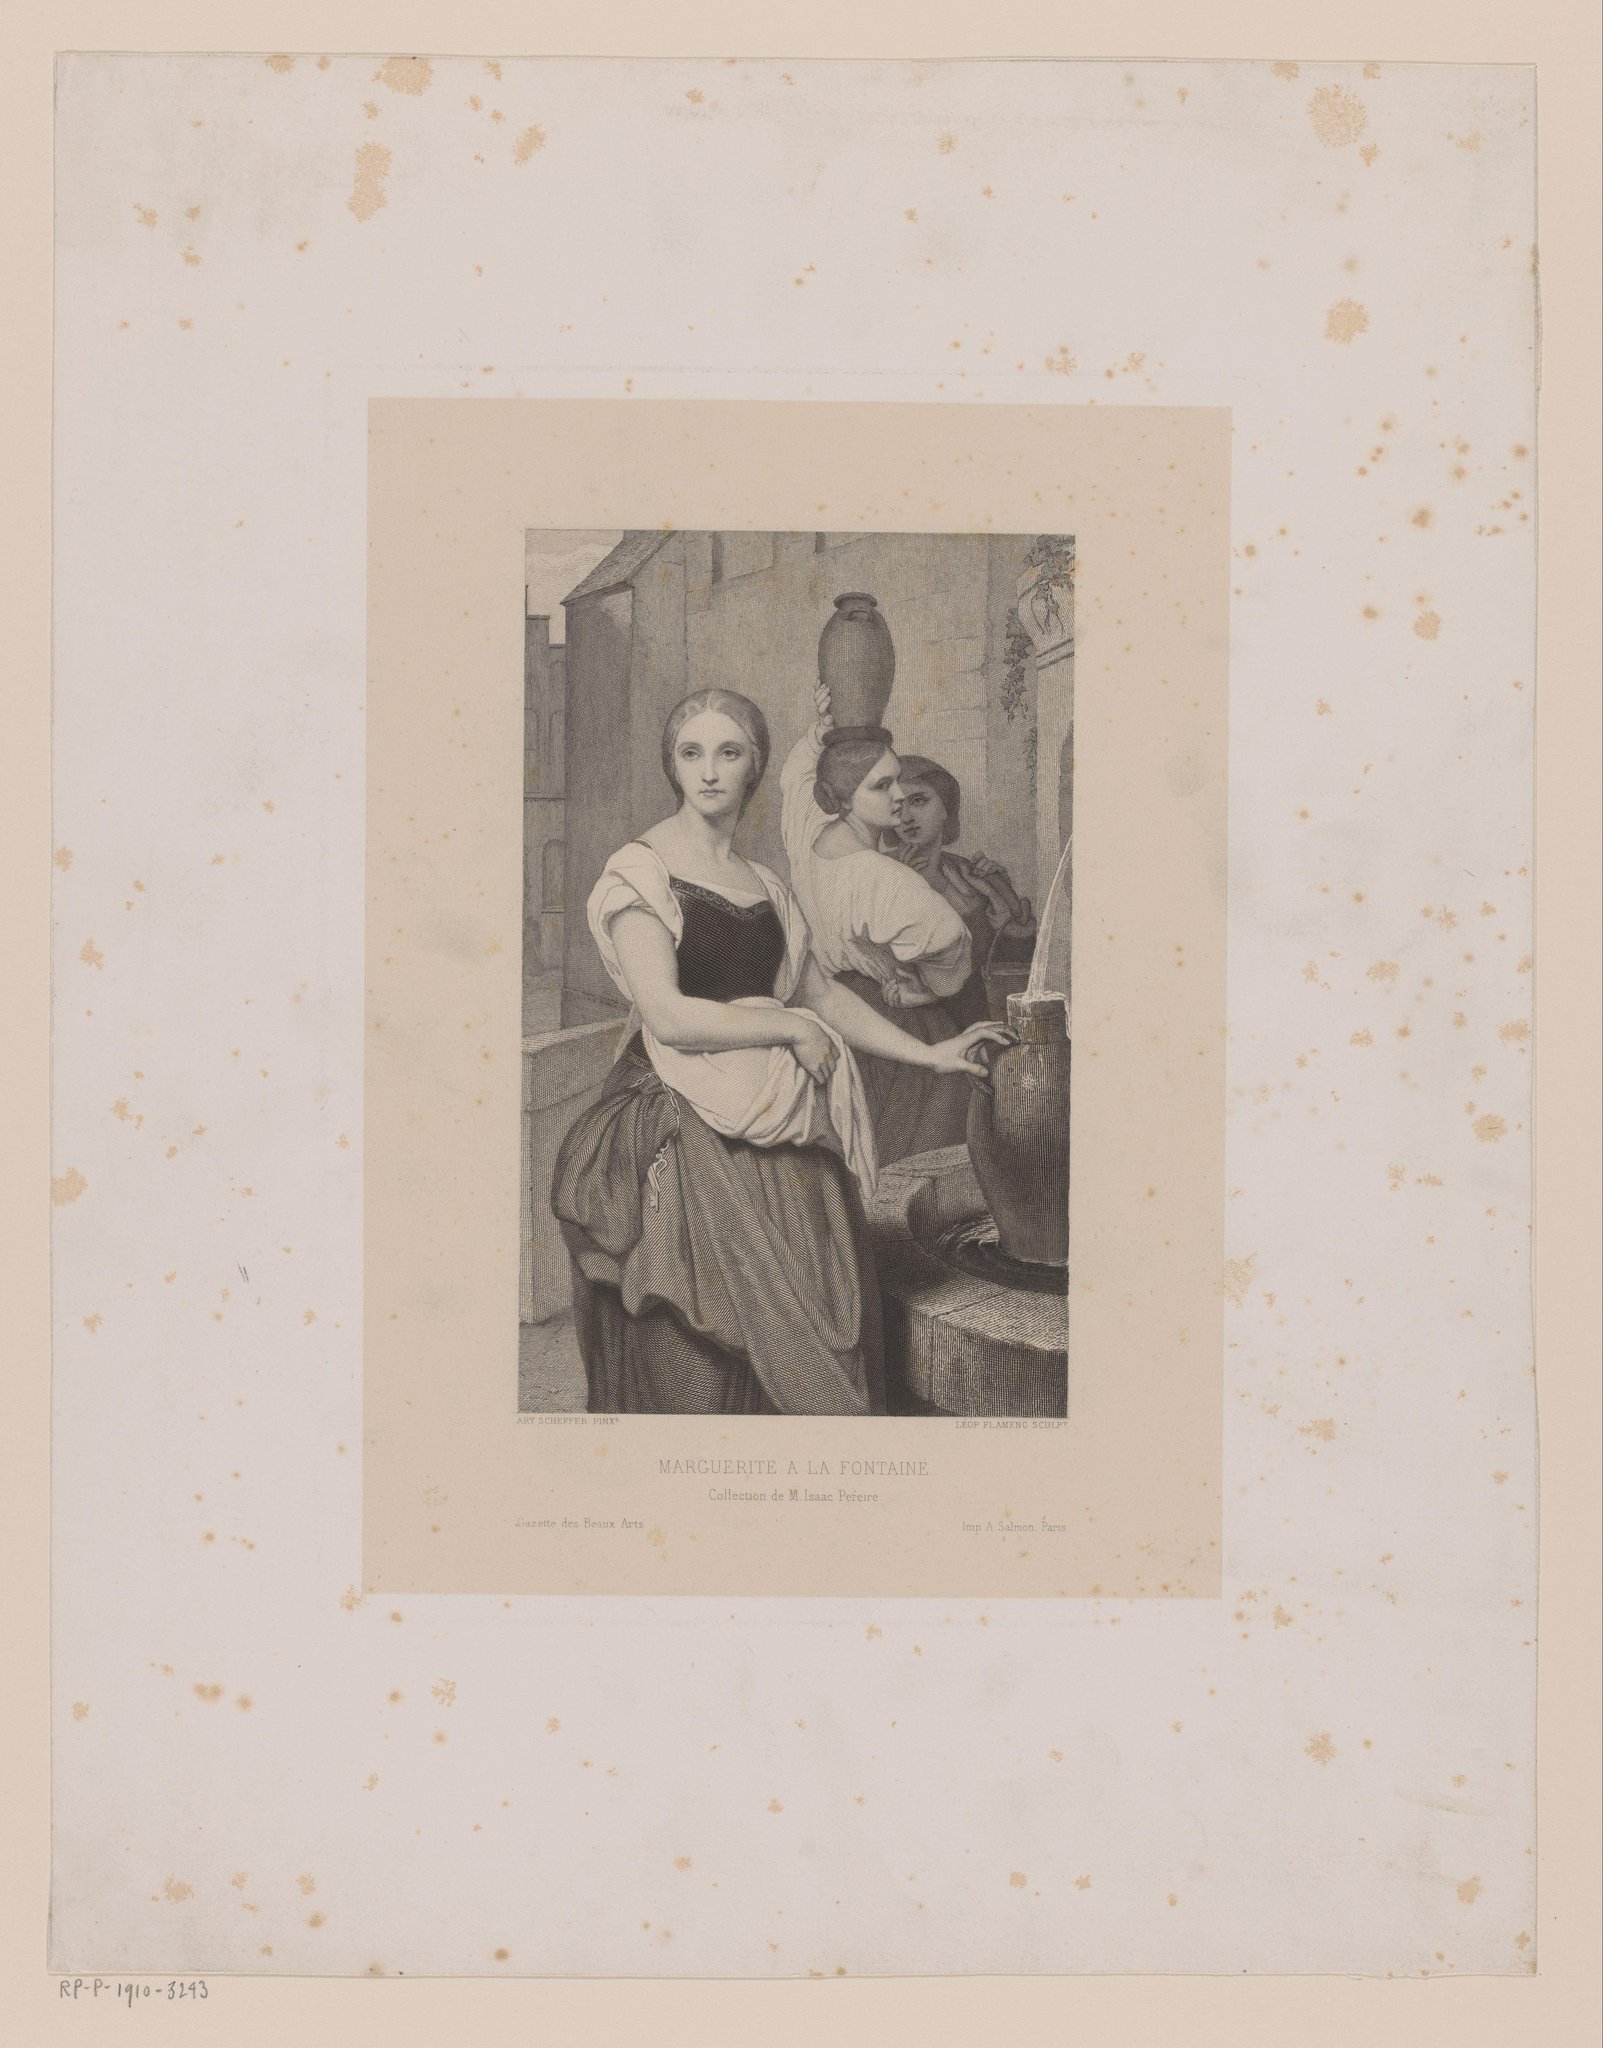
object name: print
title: Marguerite a la fontaine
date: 1864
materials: paper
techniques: engraving, etching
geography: paris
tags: well, ornamental fountain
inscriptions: collector's mark: Lugt 2228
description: Prent uit: Gazette des beaux-arts (1864), dl. 1, p. 196